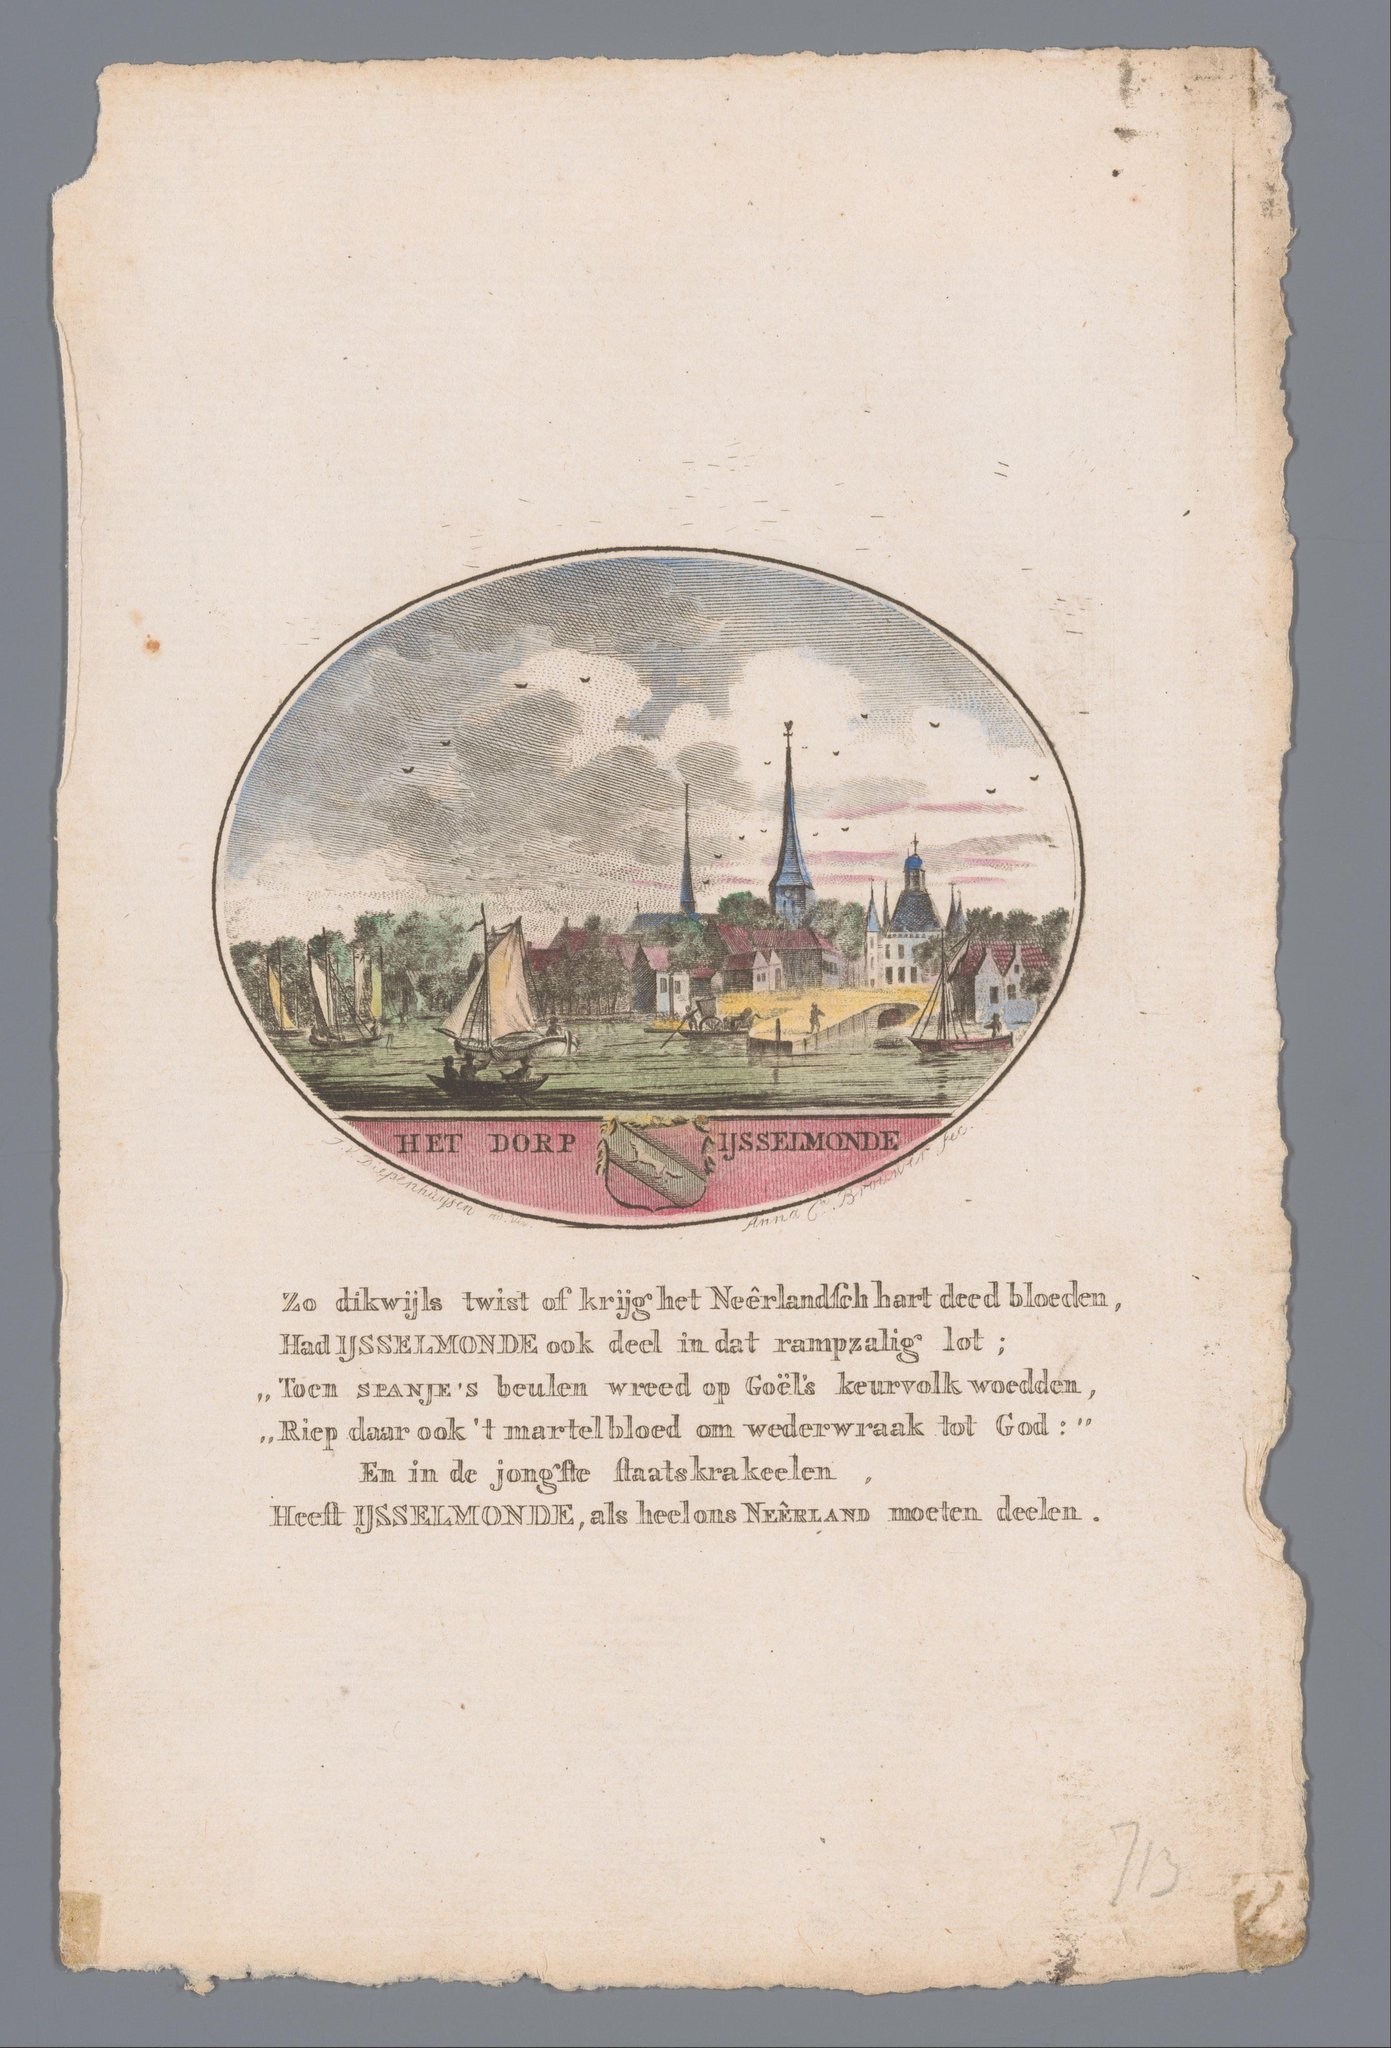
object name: print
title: Gezicht op IJsselmonde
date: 1793-1801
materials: paper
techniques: etching, hand coloring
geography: amsterdam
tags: prospect of village, silhouette of village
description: Afkomstig uit: Ollefen, L. van. De Nederlandsche stad- en dorp-beschrijver. Amsterdam: Hendrik Arend Banse, 1793-1801.